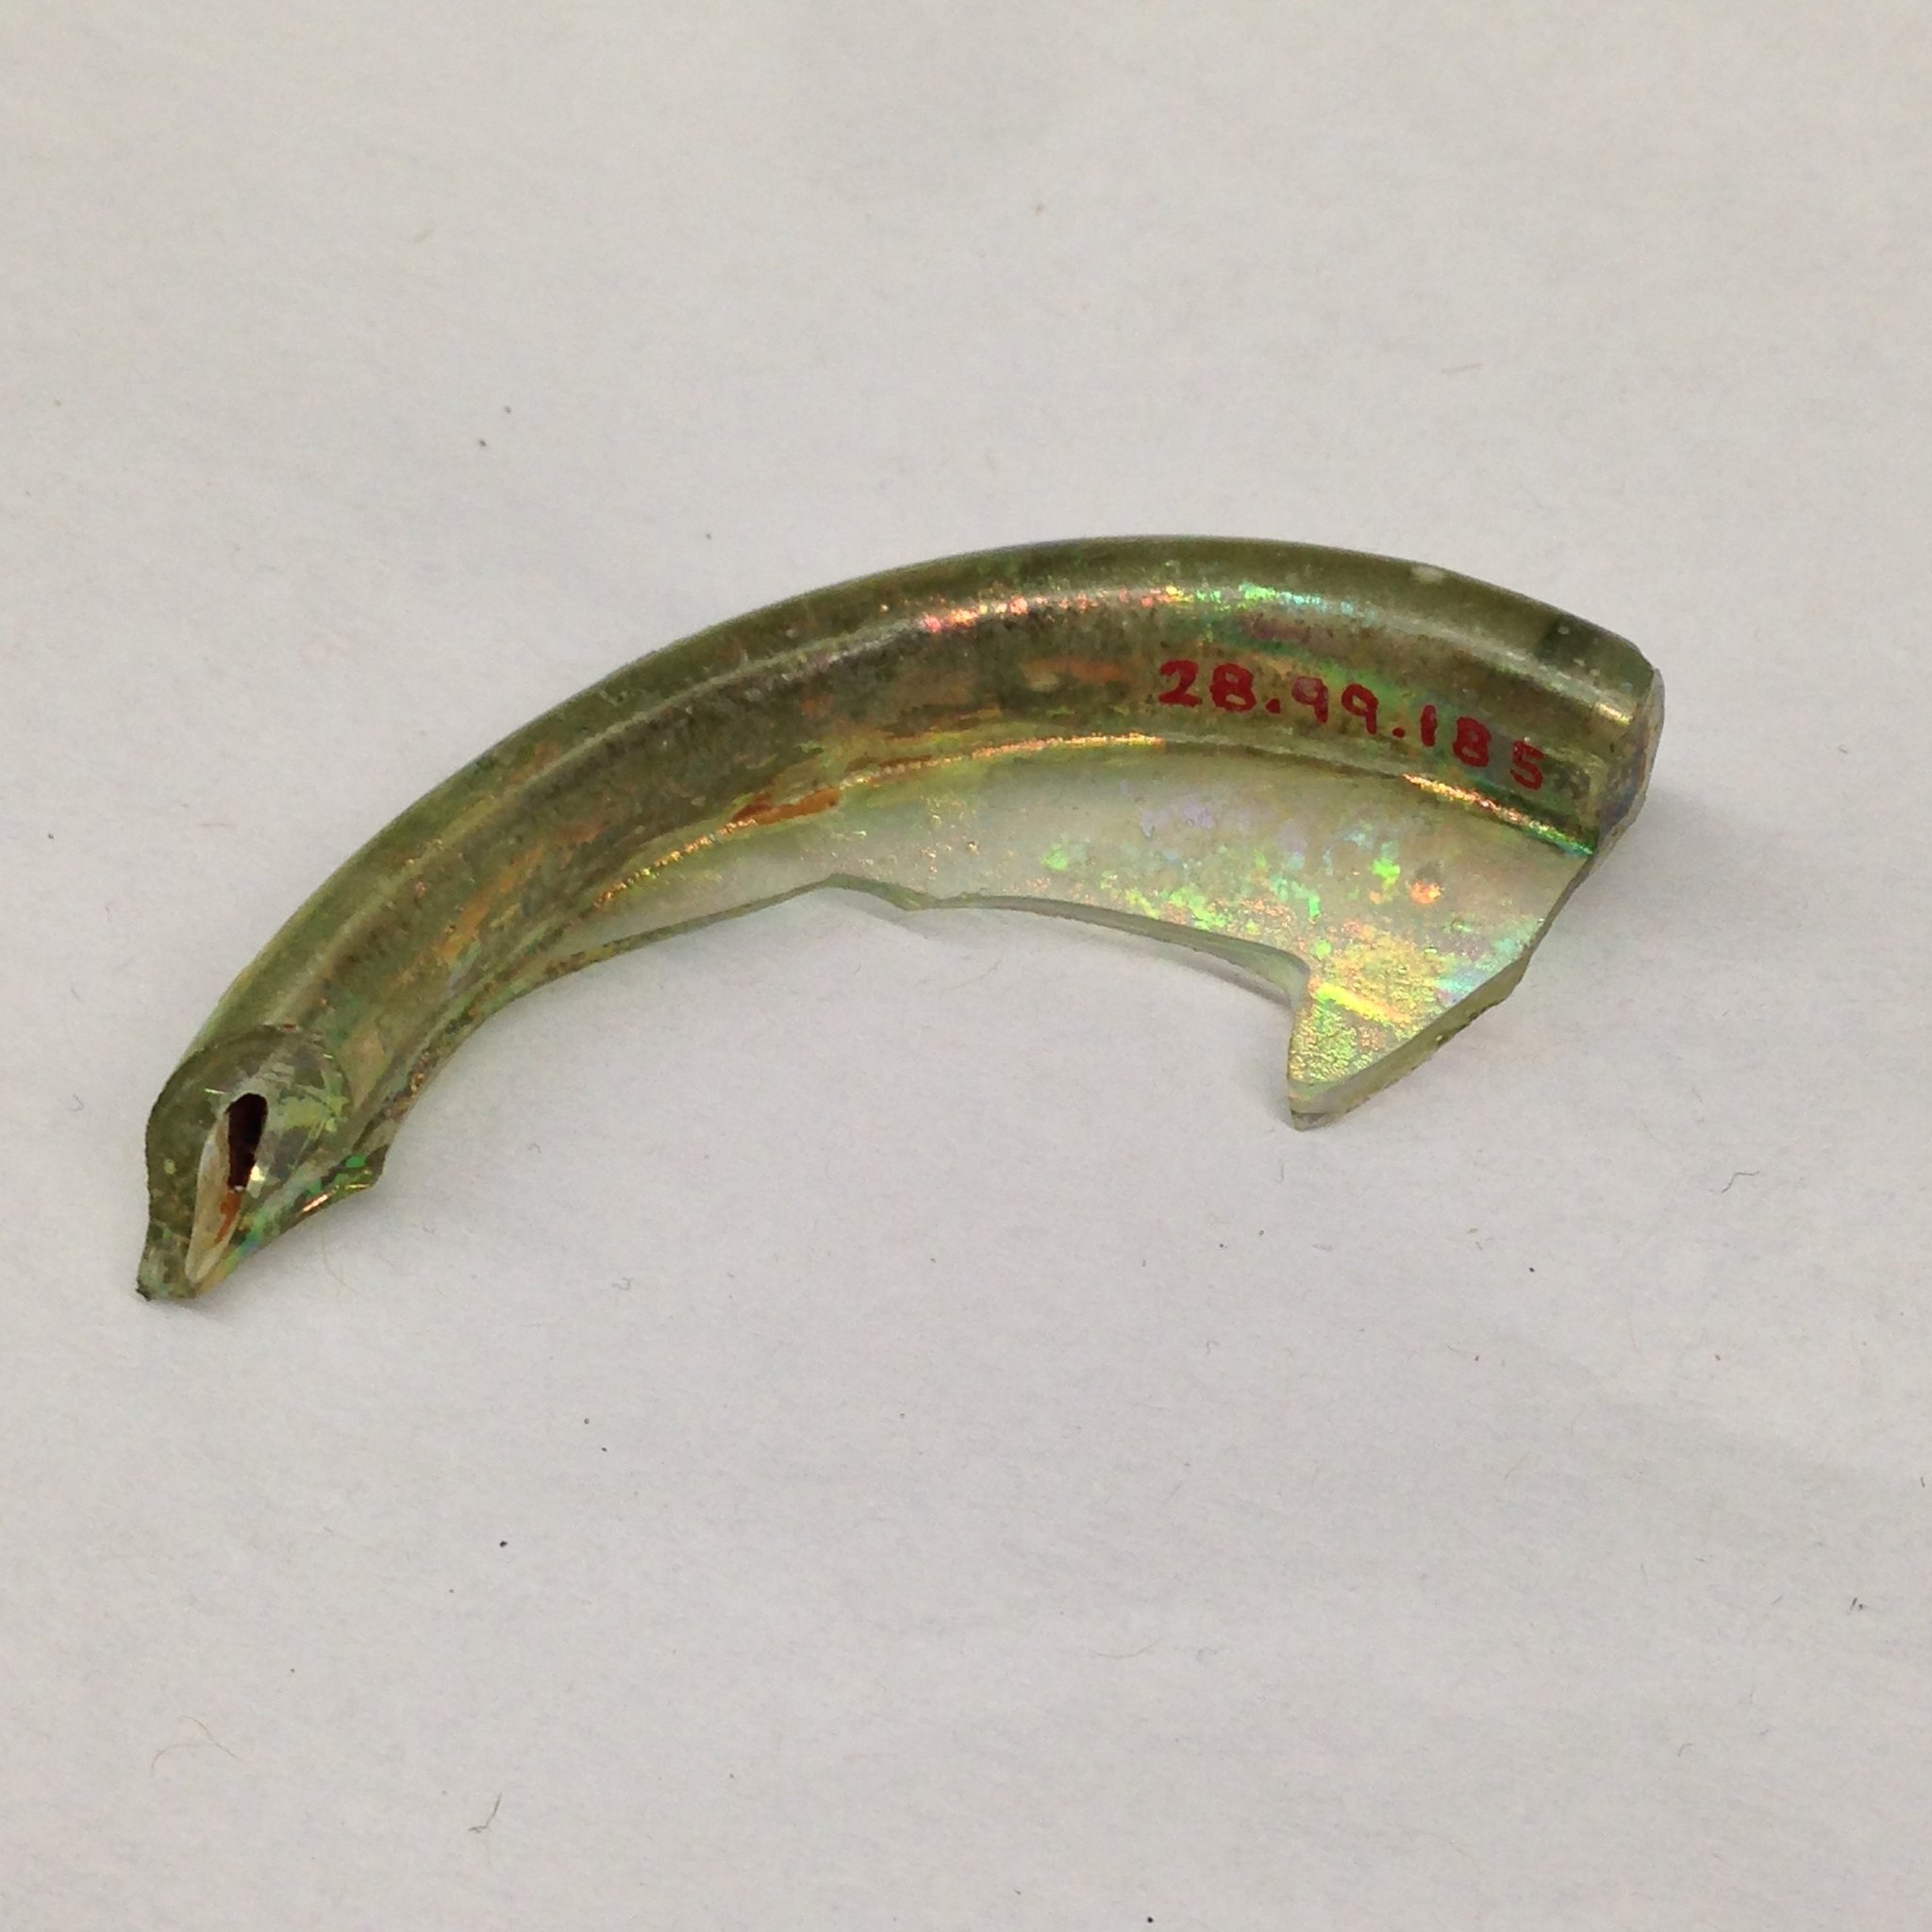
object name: fragment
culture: european or middle eastern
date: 1150-1250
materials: ceramic, glass